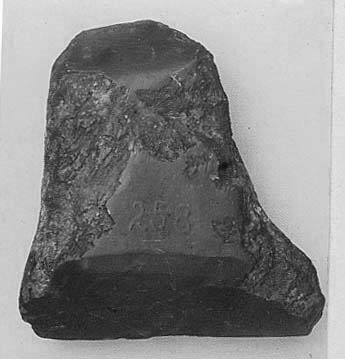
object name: hatchet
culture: north american, alaskan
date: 1902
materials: jade